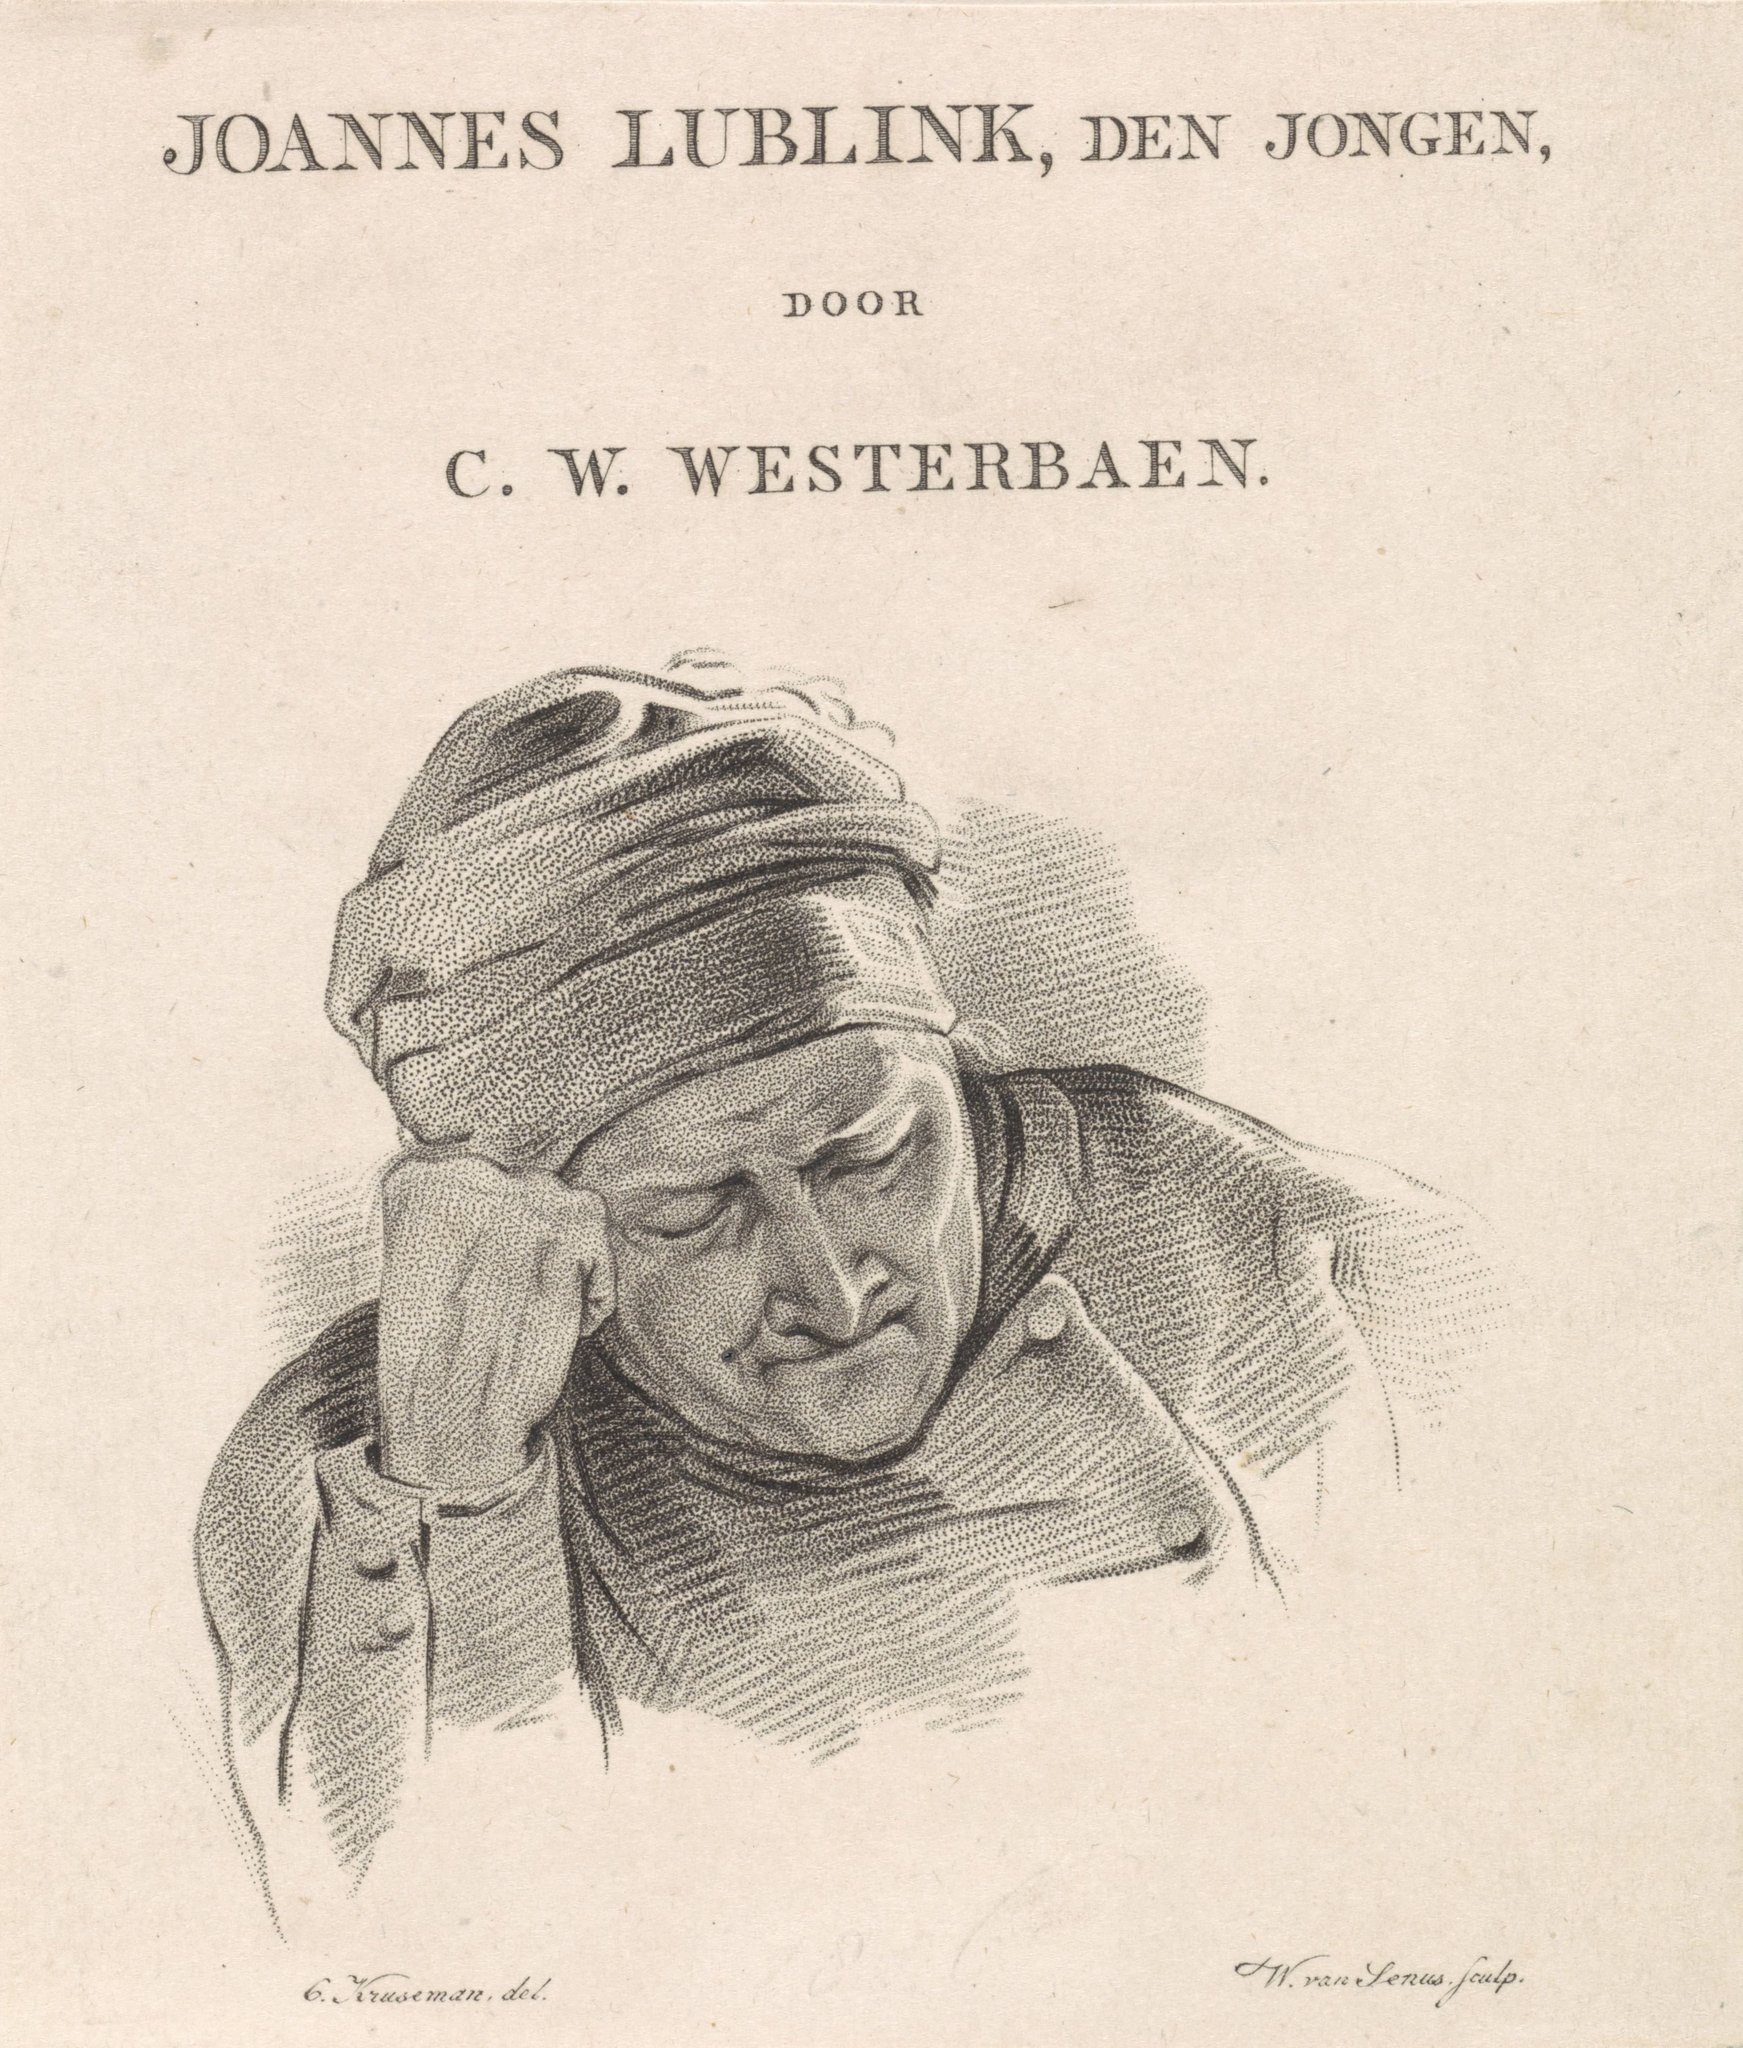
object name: print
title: Portret van Johannes Lublink (de Jonge)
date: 1817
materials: paper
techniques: etching, roulette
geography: netherlands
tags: amsterdam, johannes lublink (de jonge)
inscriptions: collector's mark: Lugt 2228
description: Titelpagina voor: Westerbaen, Cornelis Willem. Lofrede op Joannes Lublink, den jongen. Amsterdam: Jan ten Brink, 1817.